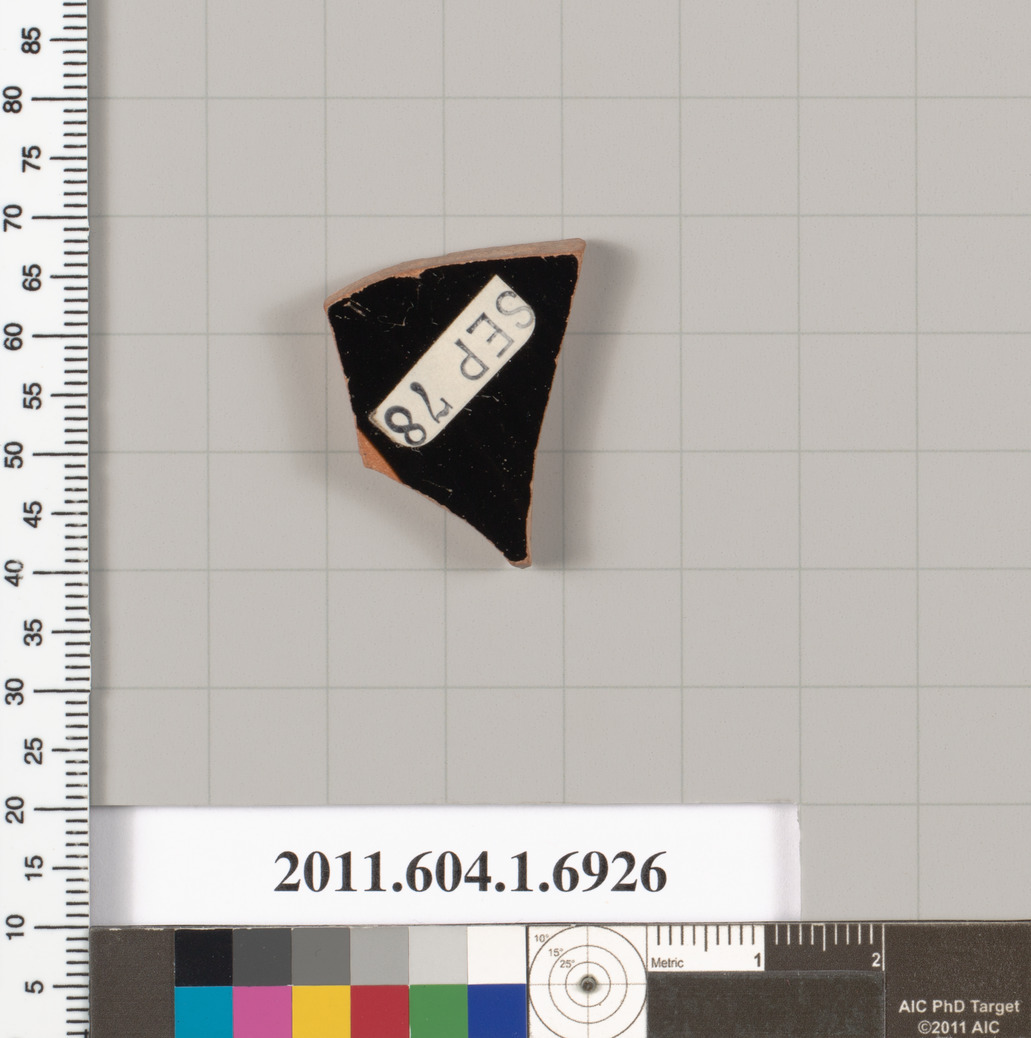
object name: kylix fragment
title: Terracotta fragment of a kylix (drinking cup)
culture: greek, attic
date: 490-470 BCE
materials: terracotta